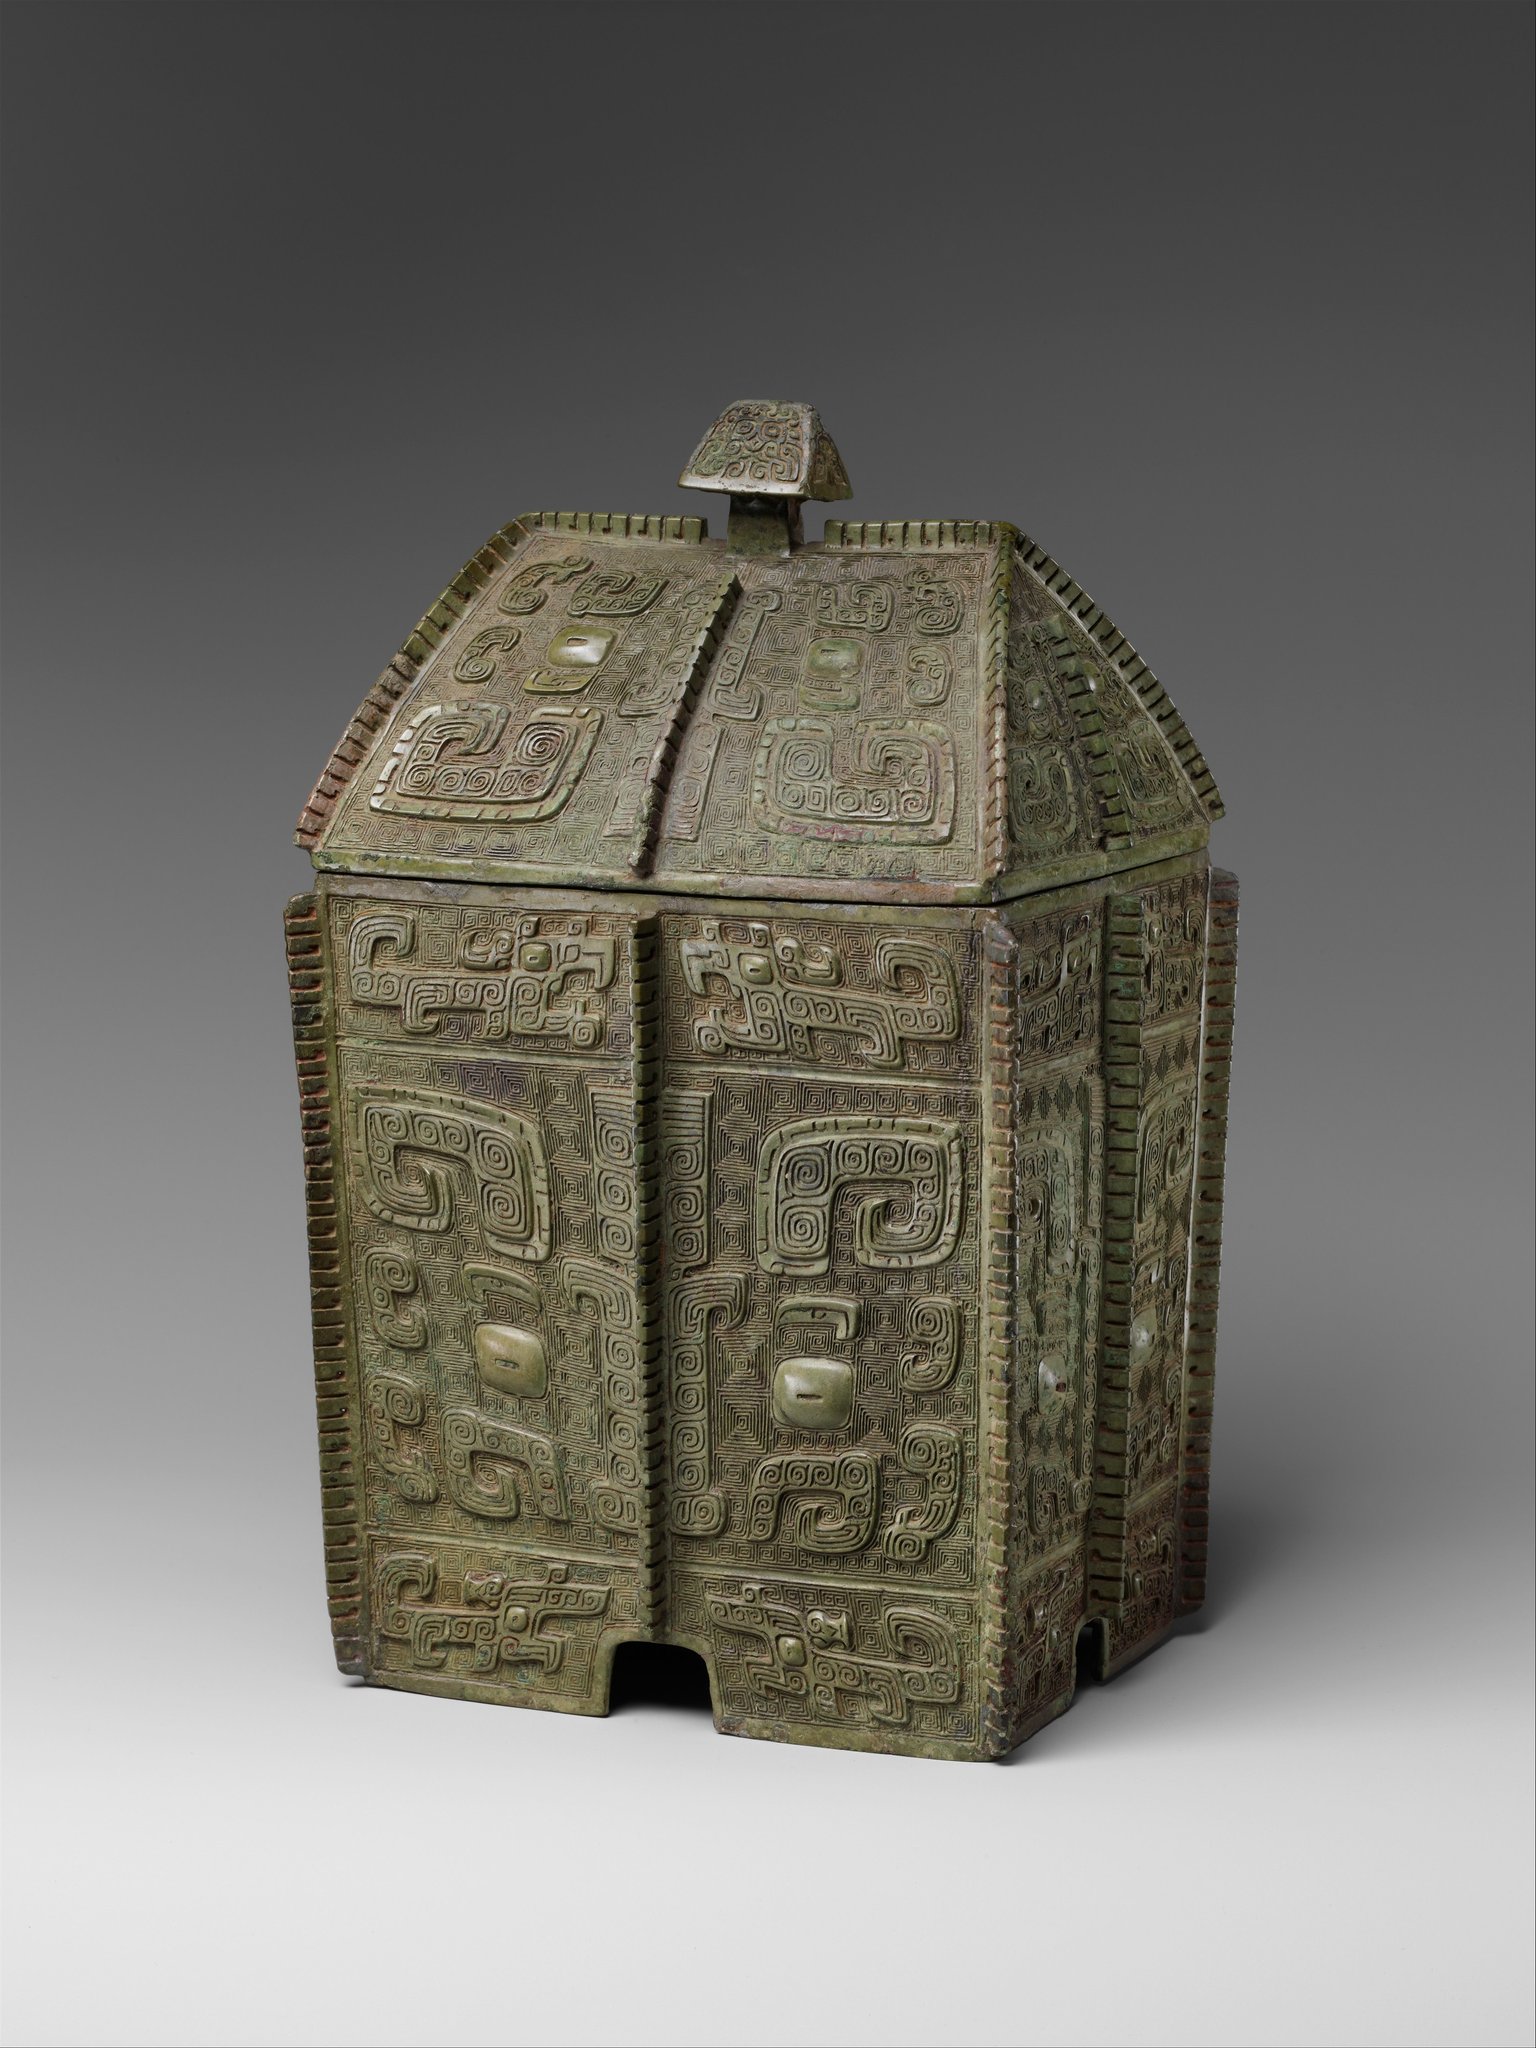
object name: wine container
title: Rectangular wine container (fangyi)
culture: chinese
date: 1200-1101 BCE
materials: bronze